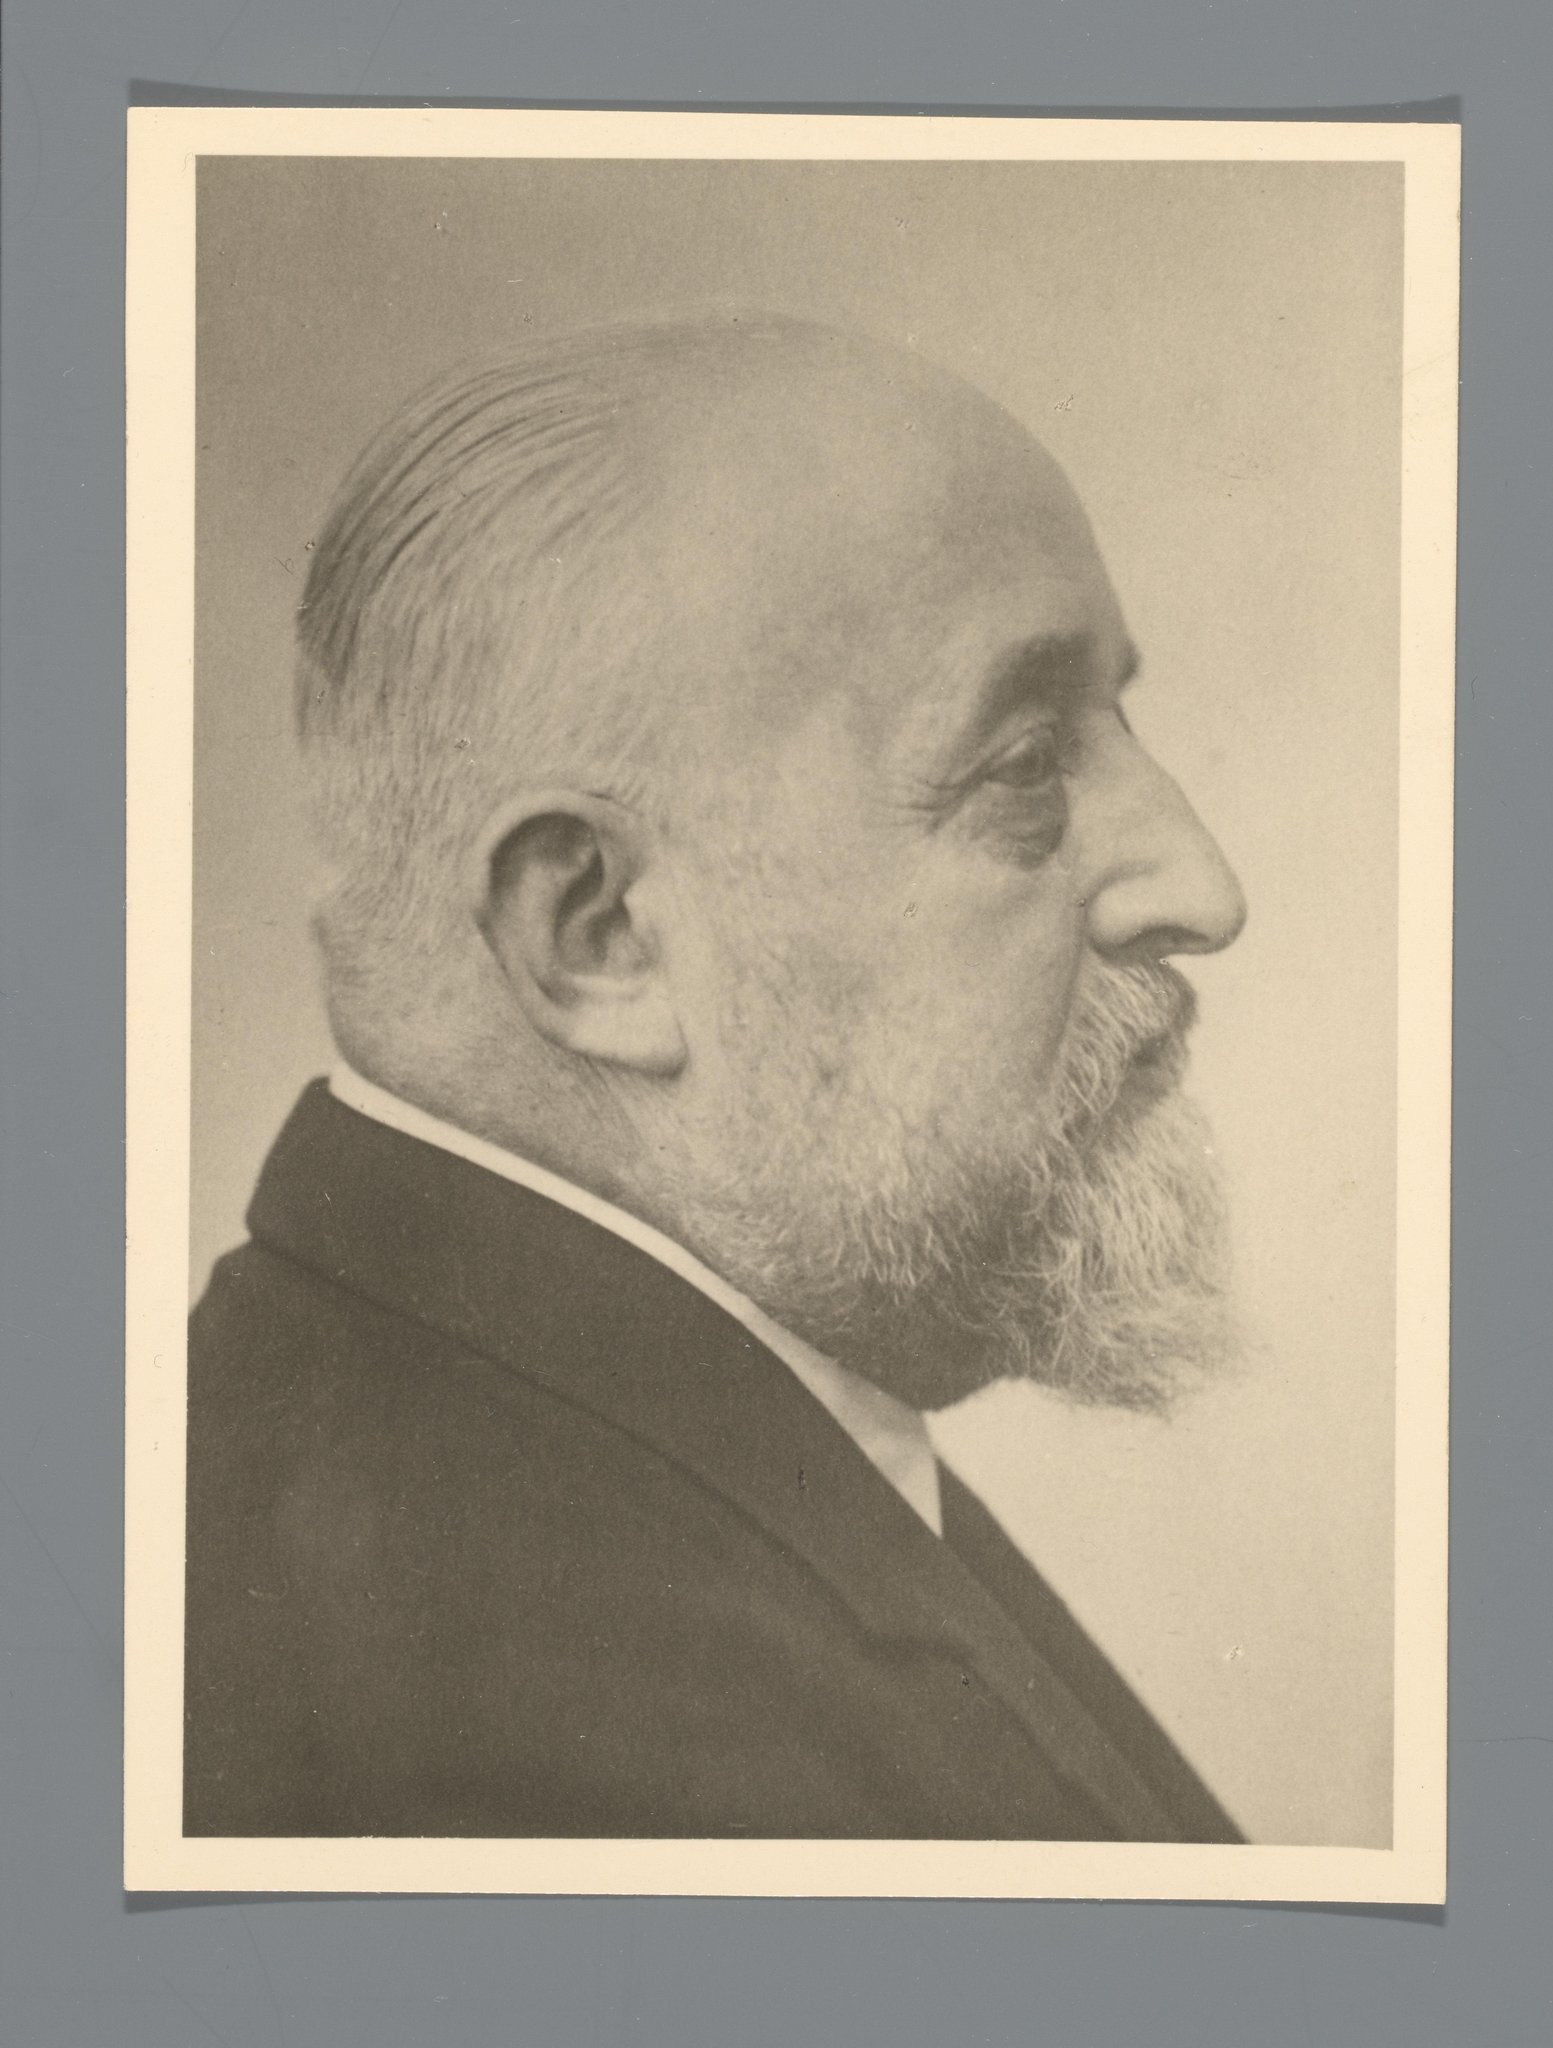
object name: photograph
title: Portret van een onbekende man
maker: cornelia hendrika jonker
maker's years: 1874-1924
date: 1920-1970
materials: photographic support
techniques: gelatin silver print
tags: historical persons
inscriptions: annotation: ‘Dr. van Tijen’